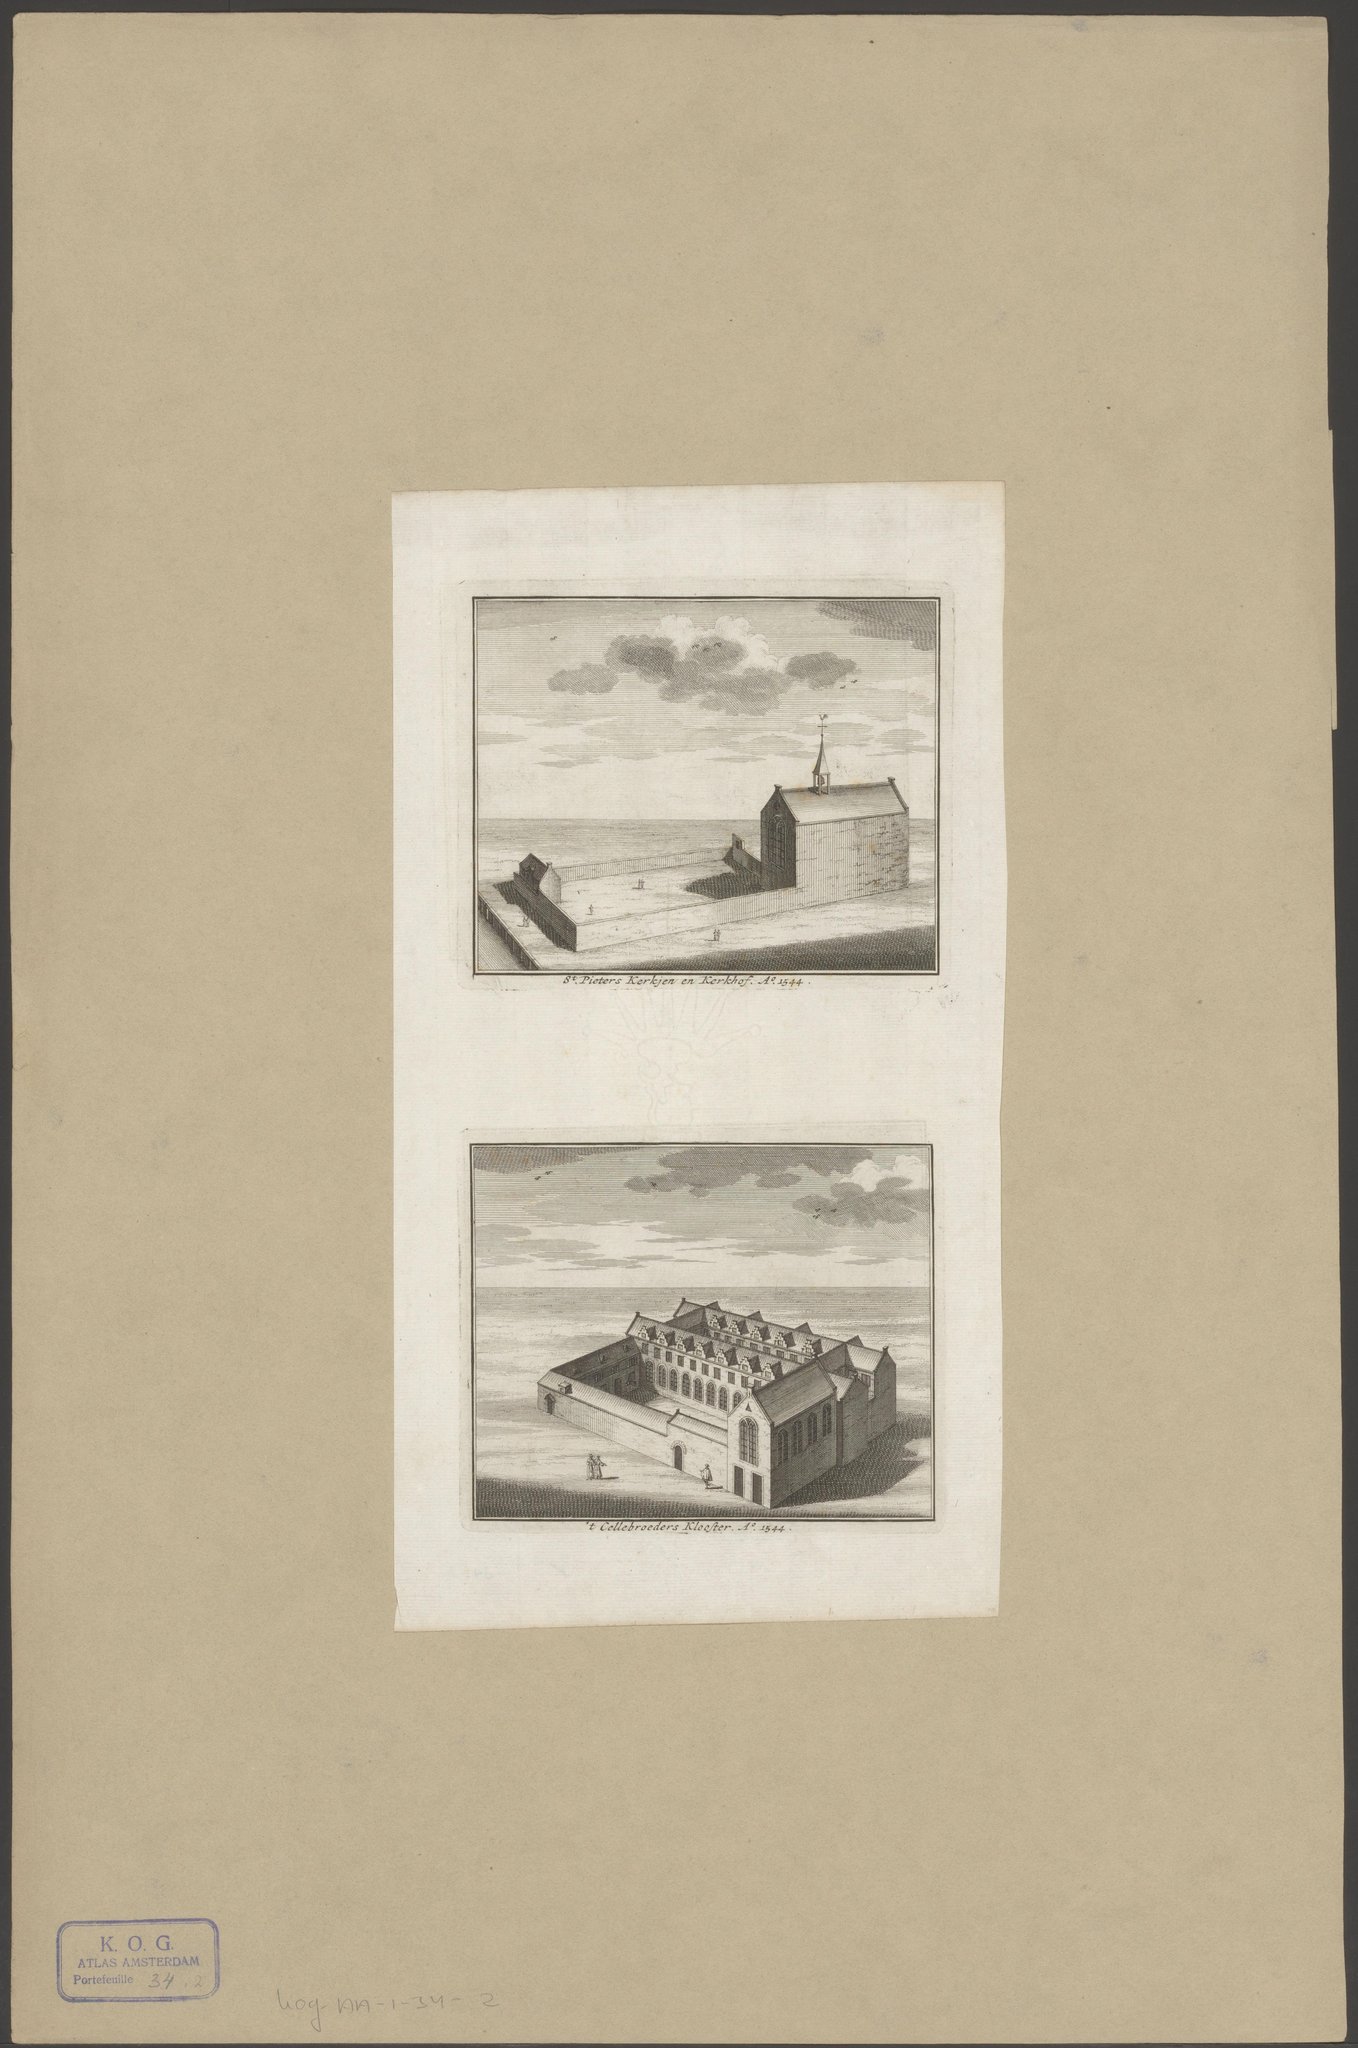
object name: print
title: 't Cellebroeders Klooster. Ao. 1544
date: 1729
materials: paper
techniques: engraving, etching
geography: northern netherlands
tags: abbey, monastery, convent ~ roman catholic church, churchyard, cemetery, church (exterior) - qq - small church, chapel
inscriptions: collector's mark: Lugt 1641b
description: Prent mogelijk uit: Long, Isaac le. Historische beschryvinge van de reformatie der stadt Amsterdam (…). Amsterdam: Johannes van Septeren (I), 1729. Dat de prent de situatie rond 1544 weergeeft, gaat terug op het feit dat voor het maken van deze en andere prenten van kloosters en kerken van voor de Alteratie (1578) is uitgegaan van de plattegrond van Cornelis Anthonisz. uit 1544, zie RP-P-OB-70.399 en RP-P-AO-20-15.